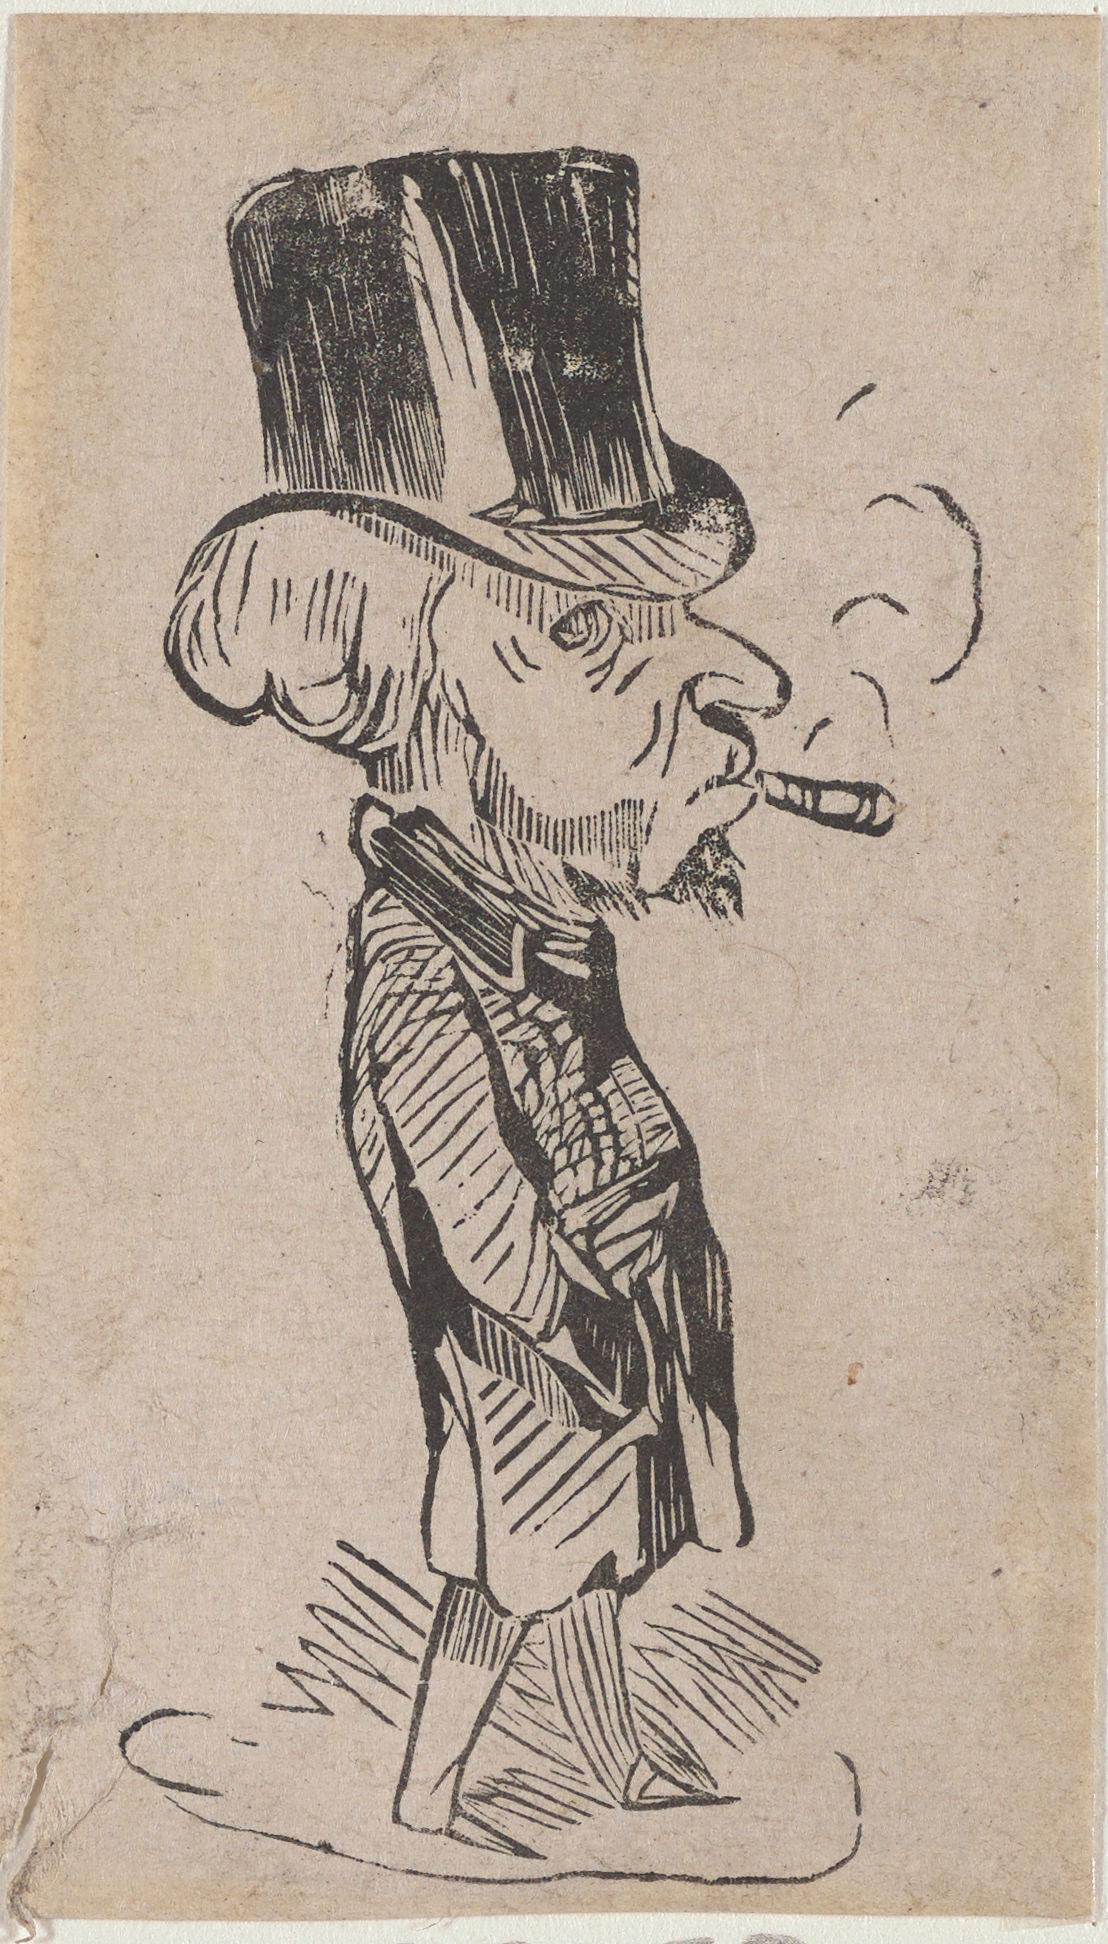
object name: print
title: Karikatuur van een man met een hoge hoed en een sigaar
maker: isaac weissenbruch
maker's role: print maker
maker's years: 1826-1912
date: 1836-1912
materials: paper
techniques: engraving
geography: netherlands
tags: cigar, head-gear: top hat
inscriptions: collector's mark: Lugt 2228